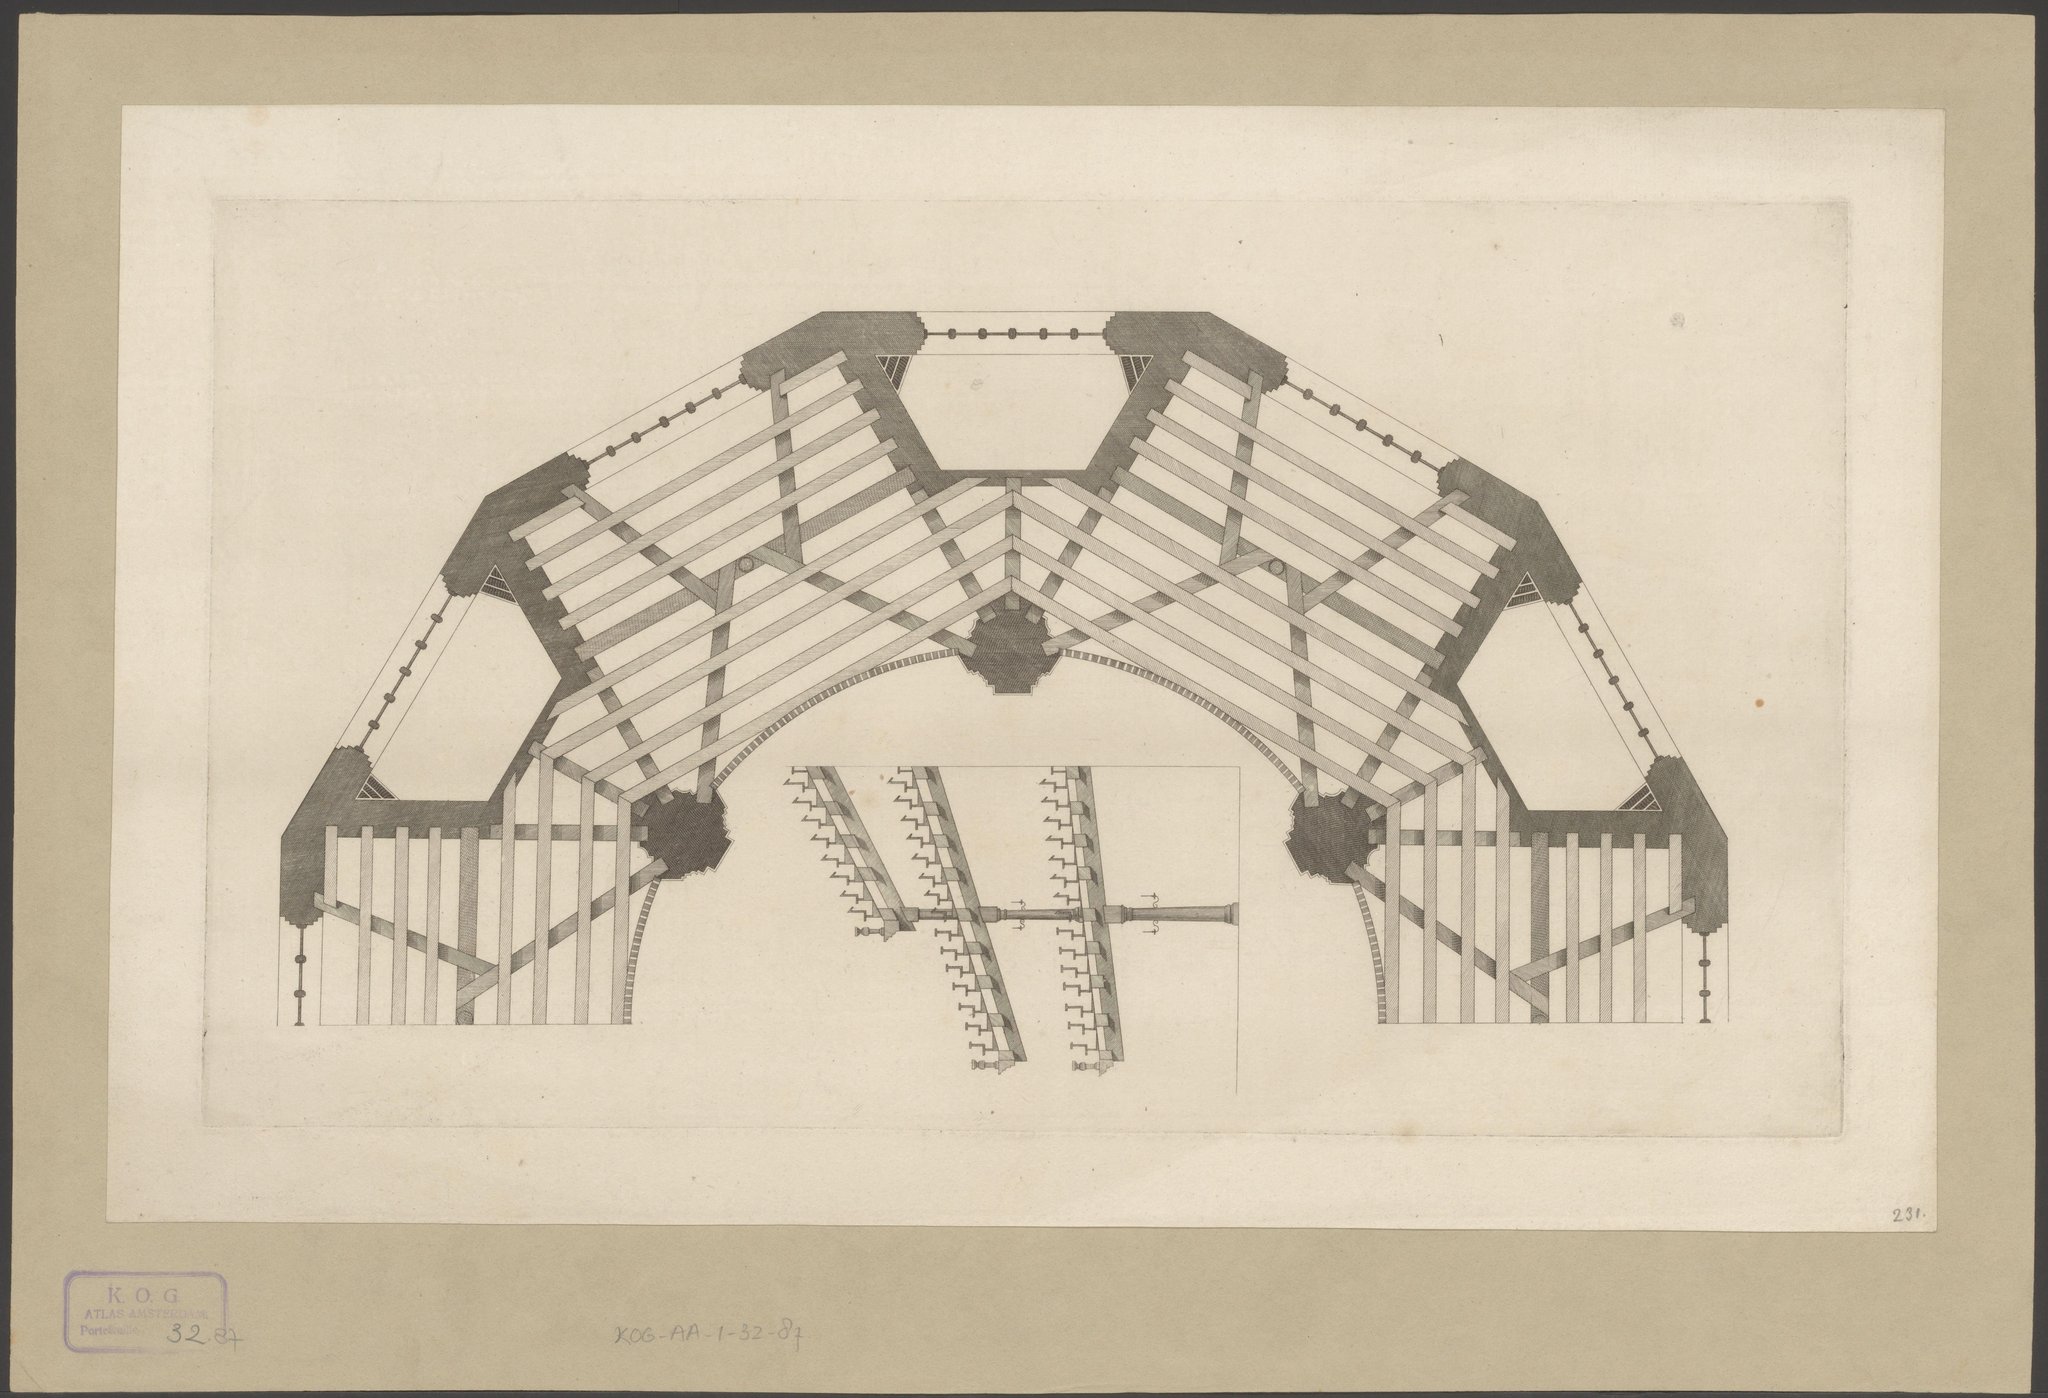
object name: area plan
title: Nieuw ontwerp voor een koepelkerk op de Botermarkt te Amsterdam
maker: daniël stopendaal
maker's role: print maker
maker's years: 1672-1726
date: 1700-1705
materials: paper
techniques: engraving, etching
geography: amsterdam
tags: interior of church, plan ~ architecture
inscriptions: collector's mark: Lugt 1641b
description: Prent maakt mogelijk onderdeel uit van de serie: Nievv desseyn tot een Seer Groote, Stercke, en om te hooren, heel bequame Coupel-Kerck (…). Deze serie van zeventien prenten werd rond 1700 in opdracht van en naar ontwerp van notaris Nicolaas Listingh gemaakt, mogelijk door Daniël Stoopendaal. Zie daarover: Long, Isaac le. Historische beschryvinge van de reformatie der stadt Amsterdam (…). Amsterdam: Johannes van Septeren (I), 1729, p. 572.